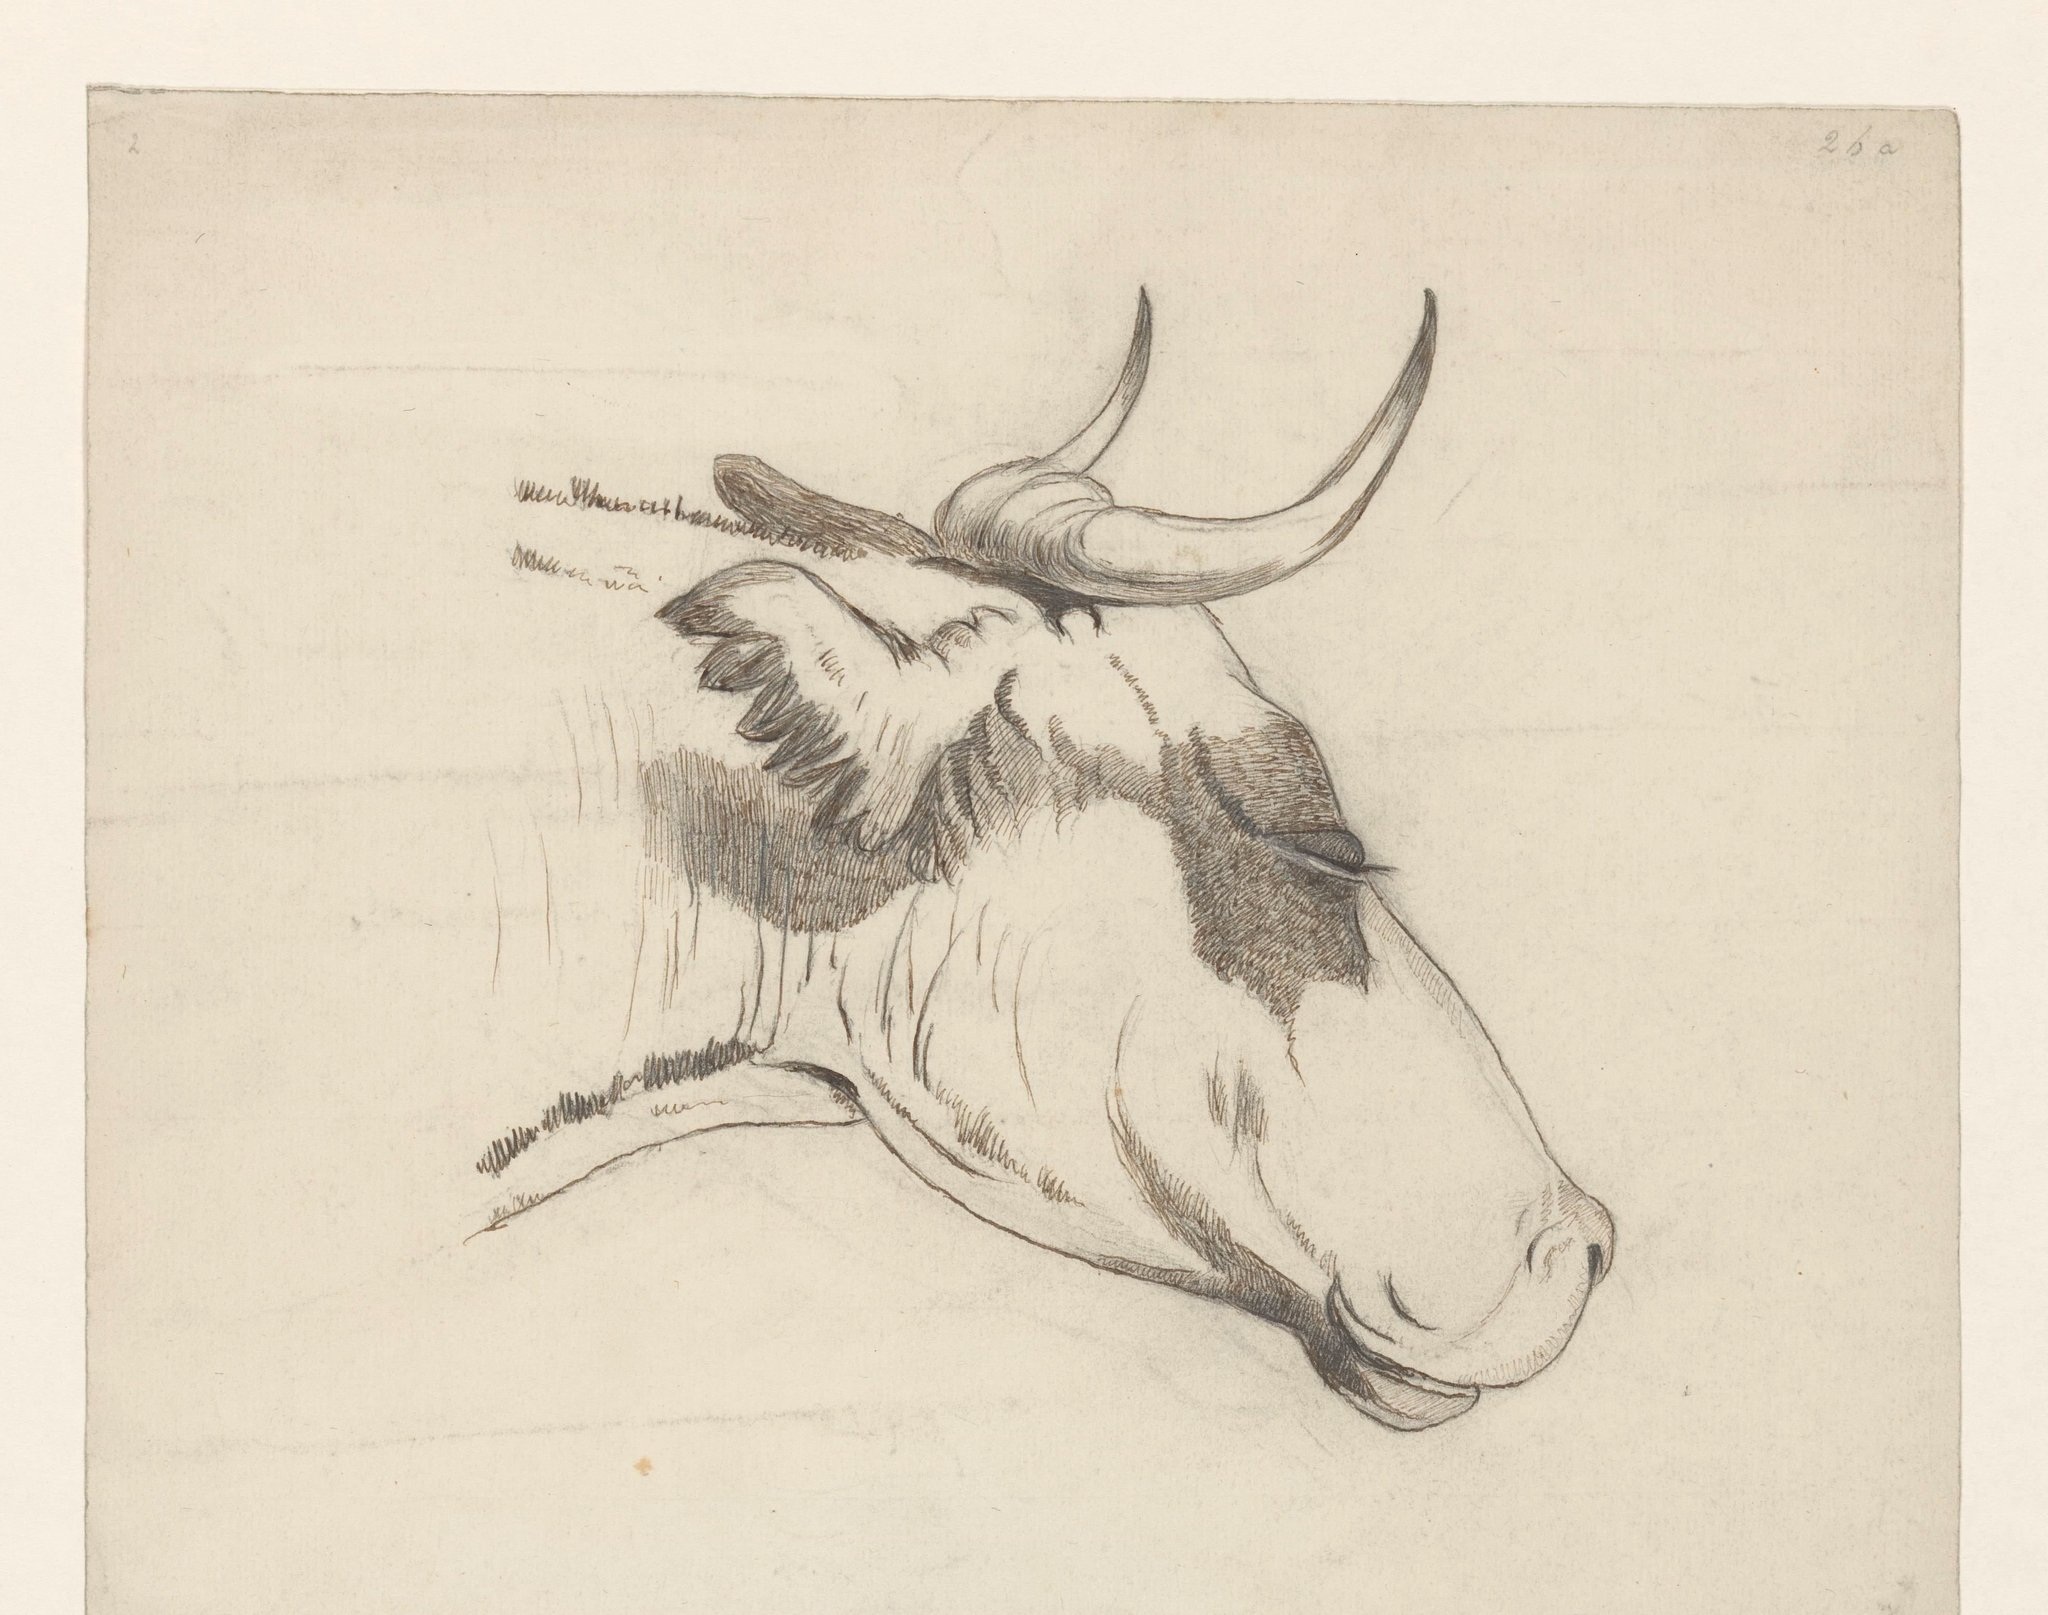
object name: drawing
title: Kop van een rund, naar rechts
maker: dirk arnoldus tavenraat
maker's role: draughtsman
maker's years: 1845-1930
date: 1855-1930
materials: ink, paper, pencil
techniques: pen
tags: bovine cattle